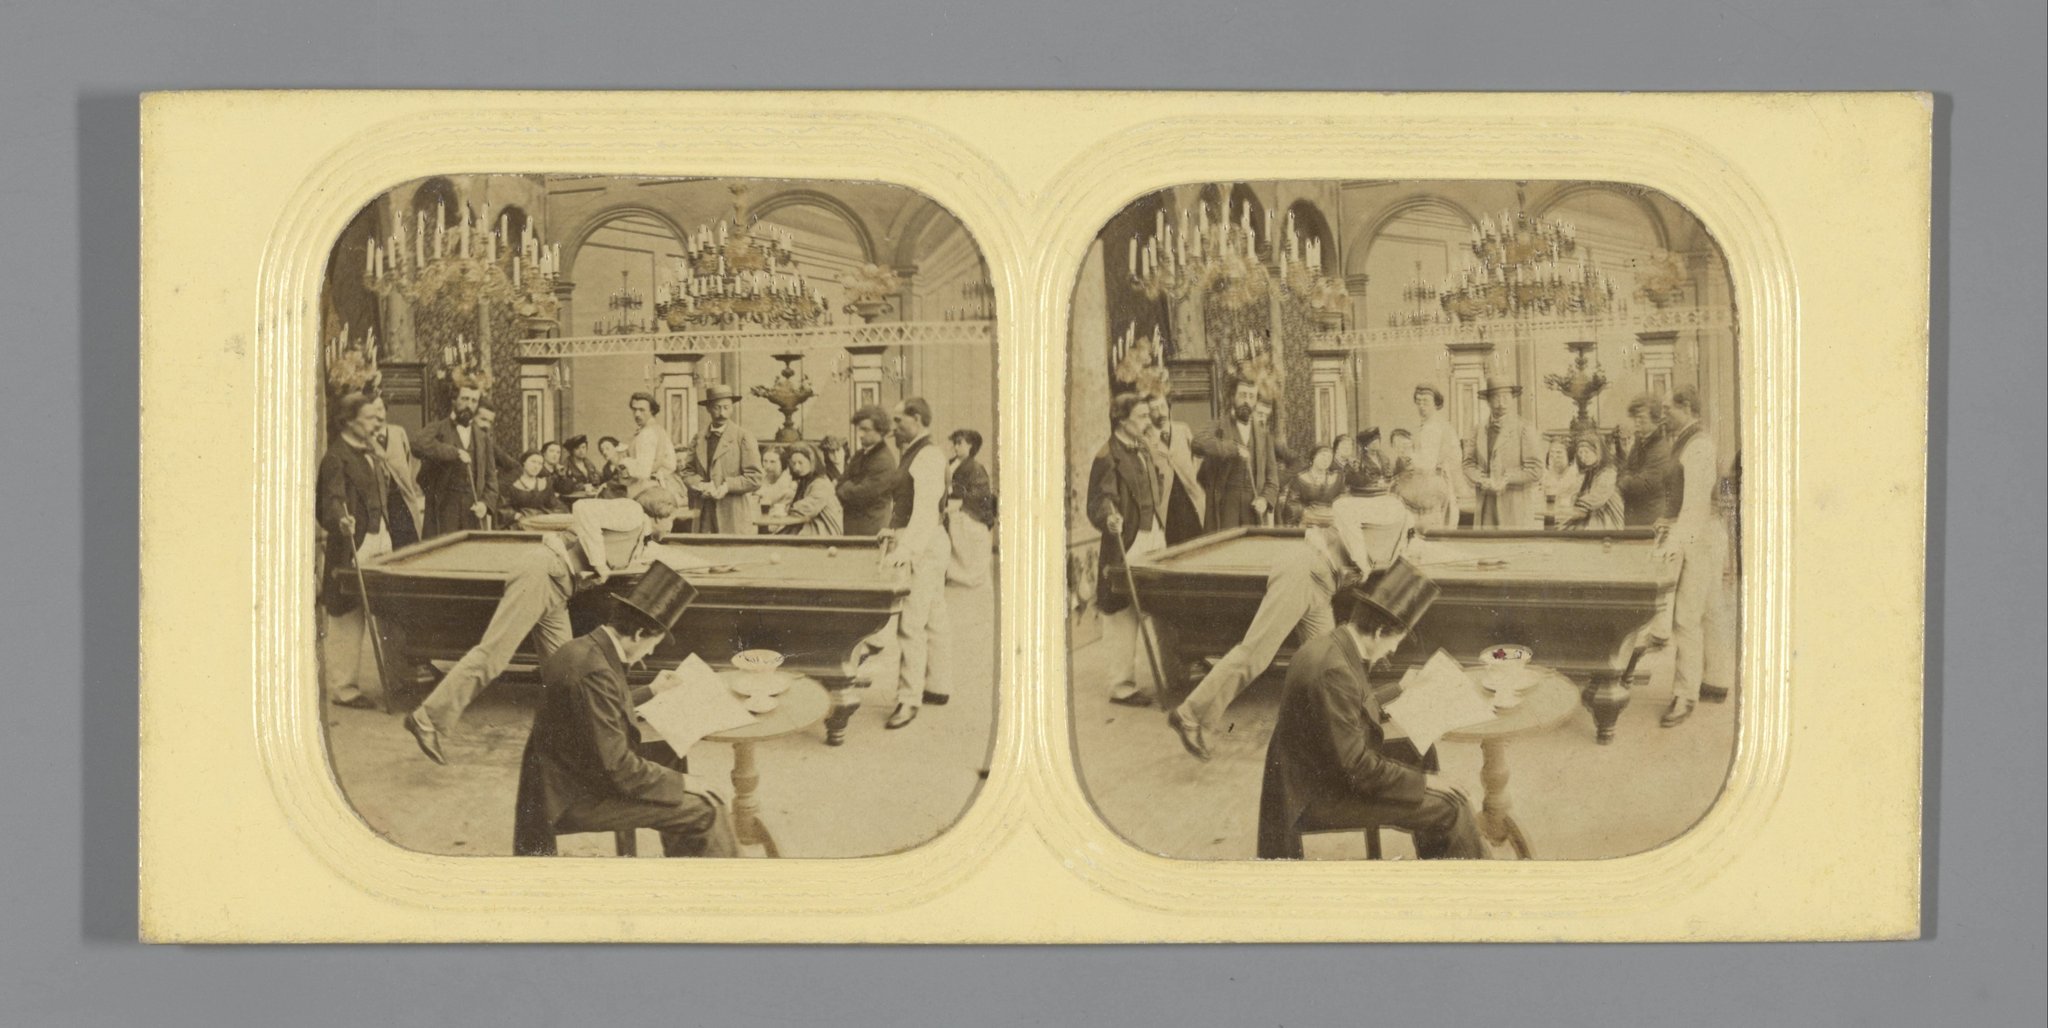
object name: tissue stereograph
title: Mannen rond biljarttafel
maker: Anonymous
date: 1862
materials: cardboard, paper, photographic support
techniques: albumen print, cutting, hand coloring, perforating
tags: billiards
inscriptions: inscription: ‘Cadeau Beurt [?] 12 Dec 1862/ M. de Kempenaer.’